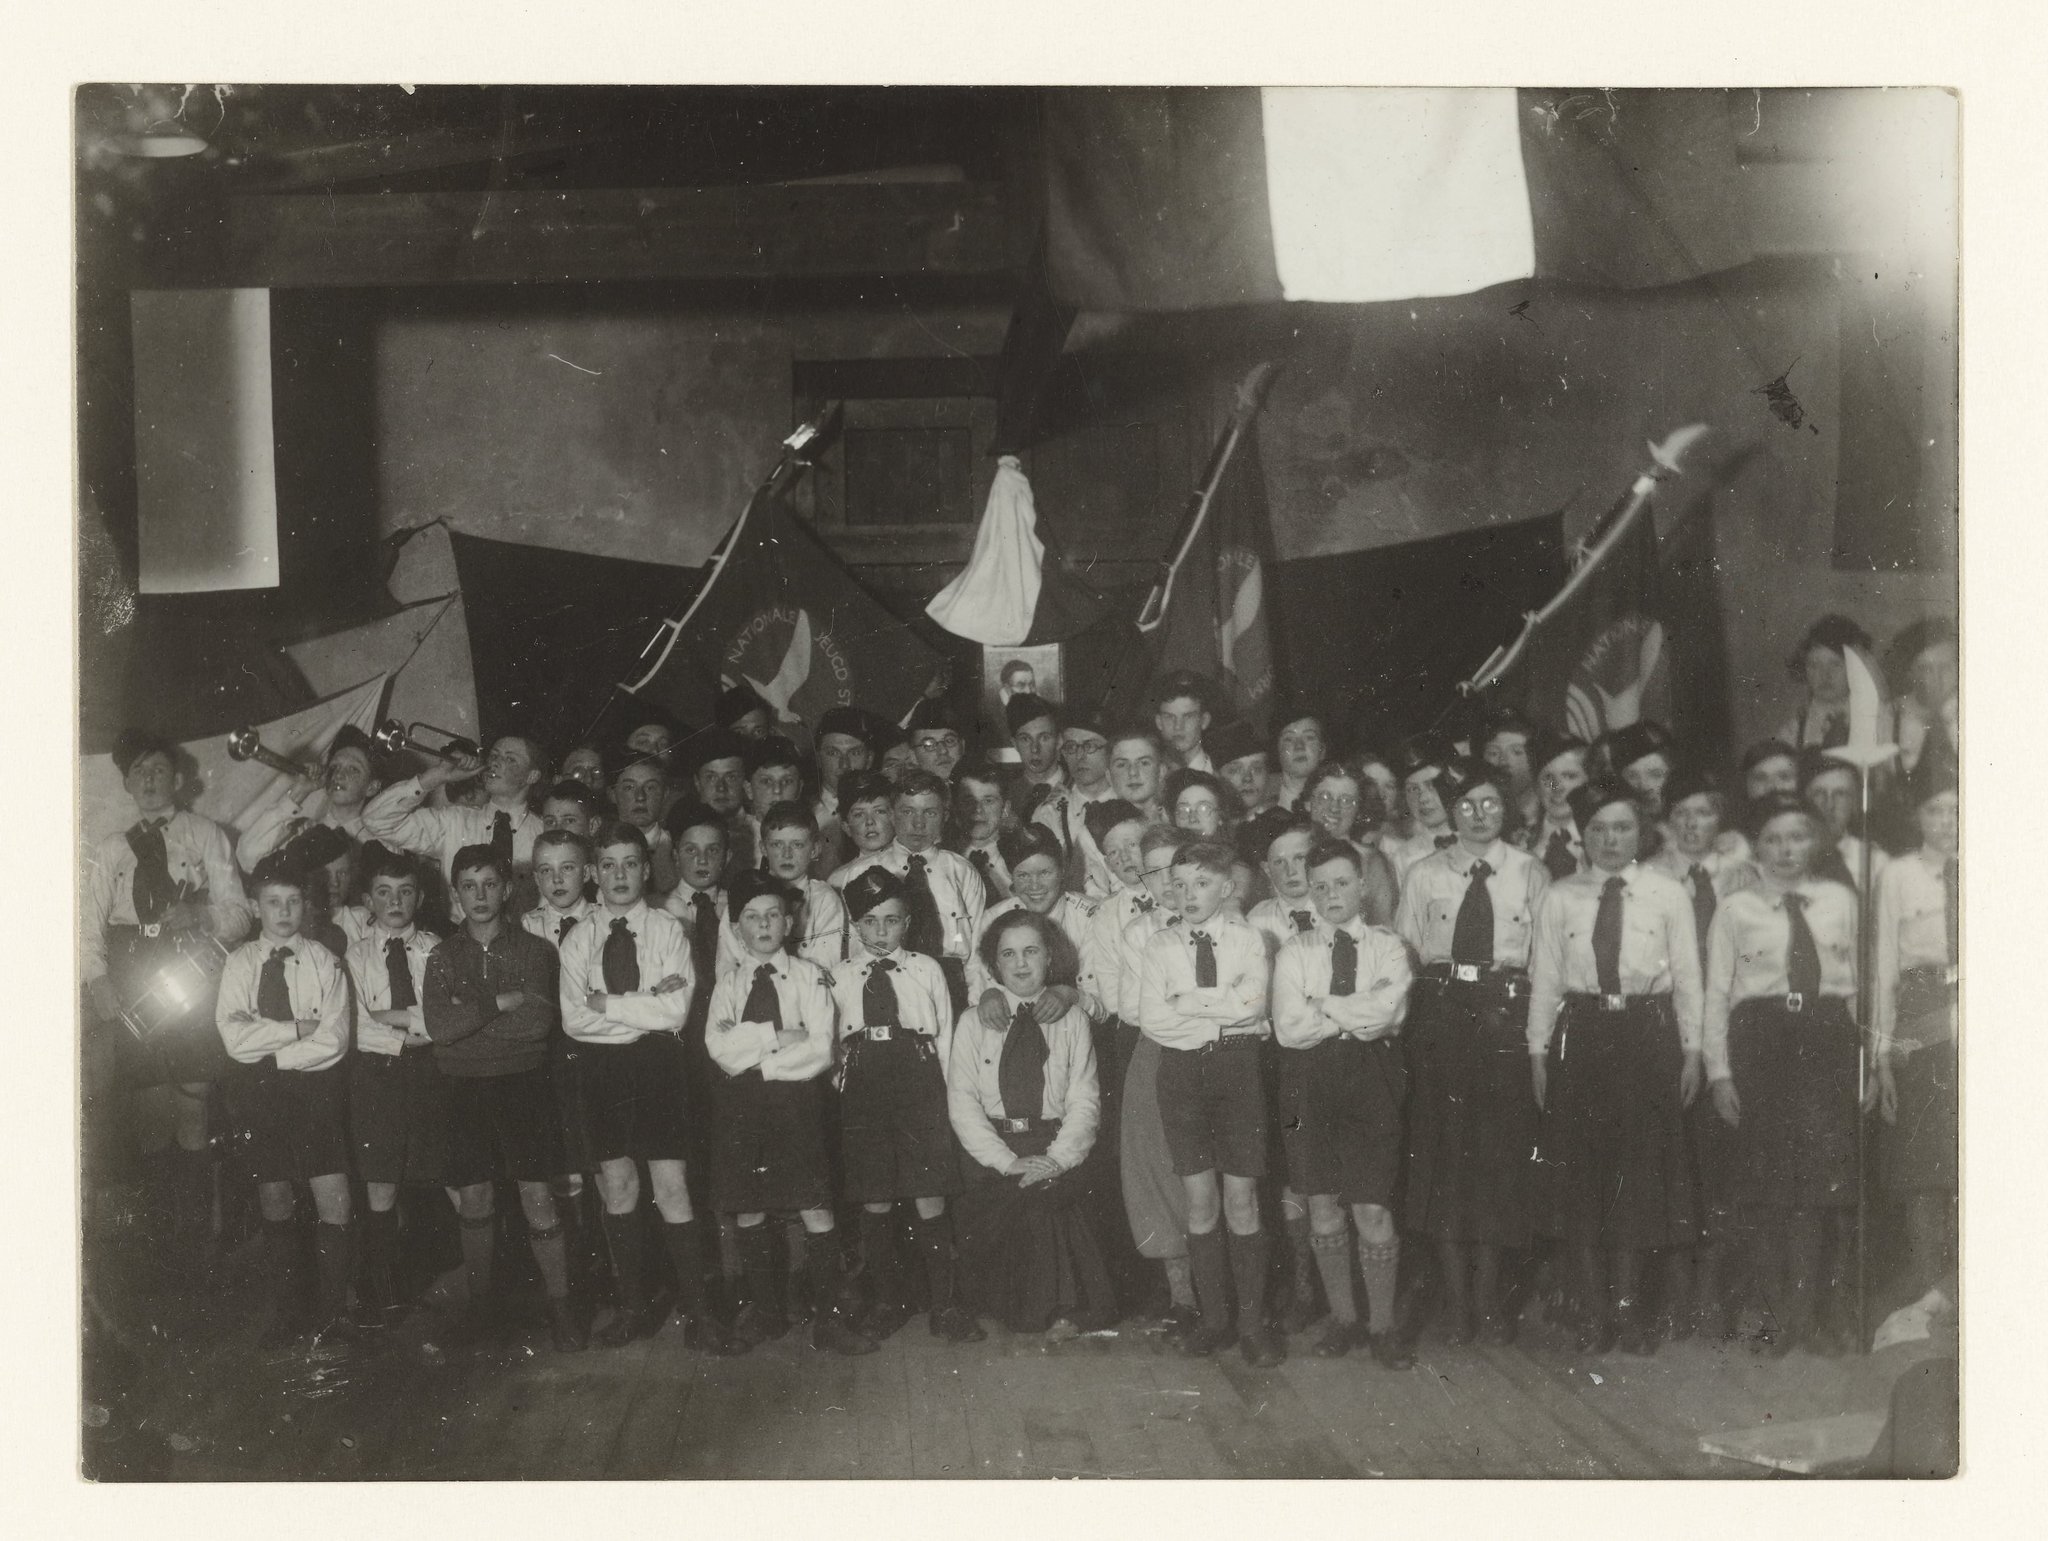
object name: photograph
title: Jeugdstorm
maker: Anonymous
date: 1934-1940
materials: photographic support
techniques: photography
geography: netherlands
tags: netherlands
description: Een groep jongens en meisjes, met volwassen begeleiders, in het uniform van de (Nationale) Jeugdstorm op een podium. Links kinderen met trompetten en een trommel. Op de achtergrond drie vlaggen van de Jeugdstorm en het portret van Willem van Oranje. Rechts staat een kind met een stok, versierd met een vliegende meeuw, symbool van de jeugdstorm.